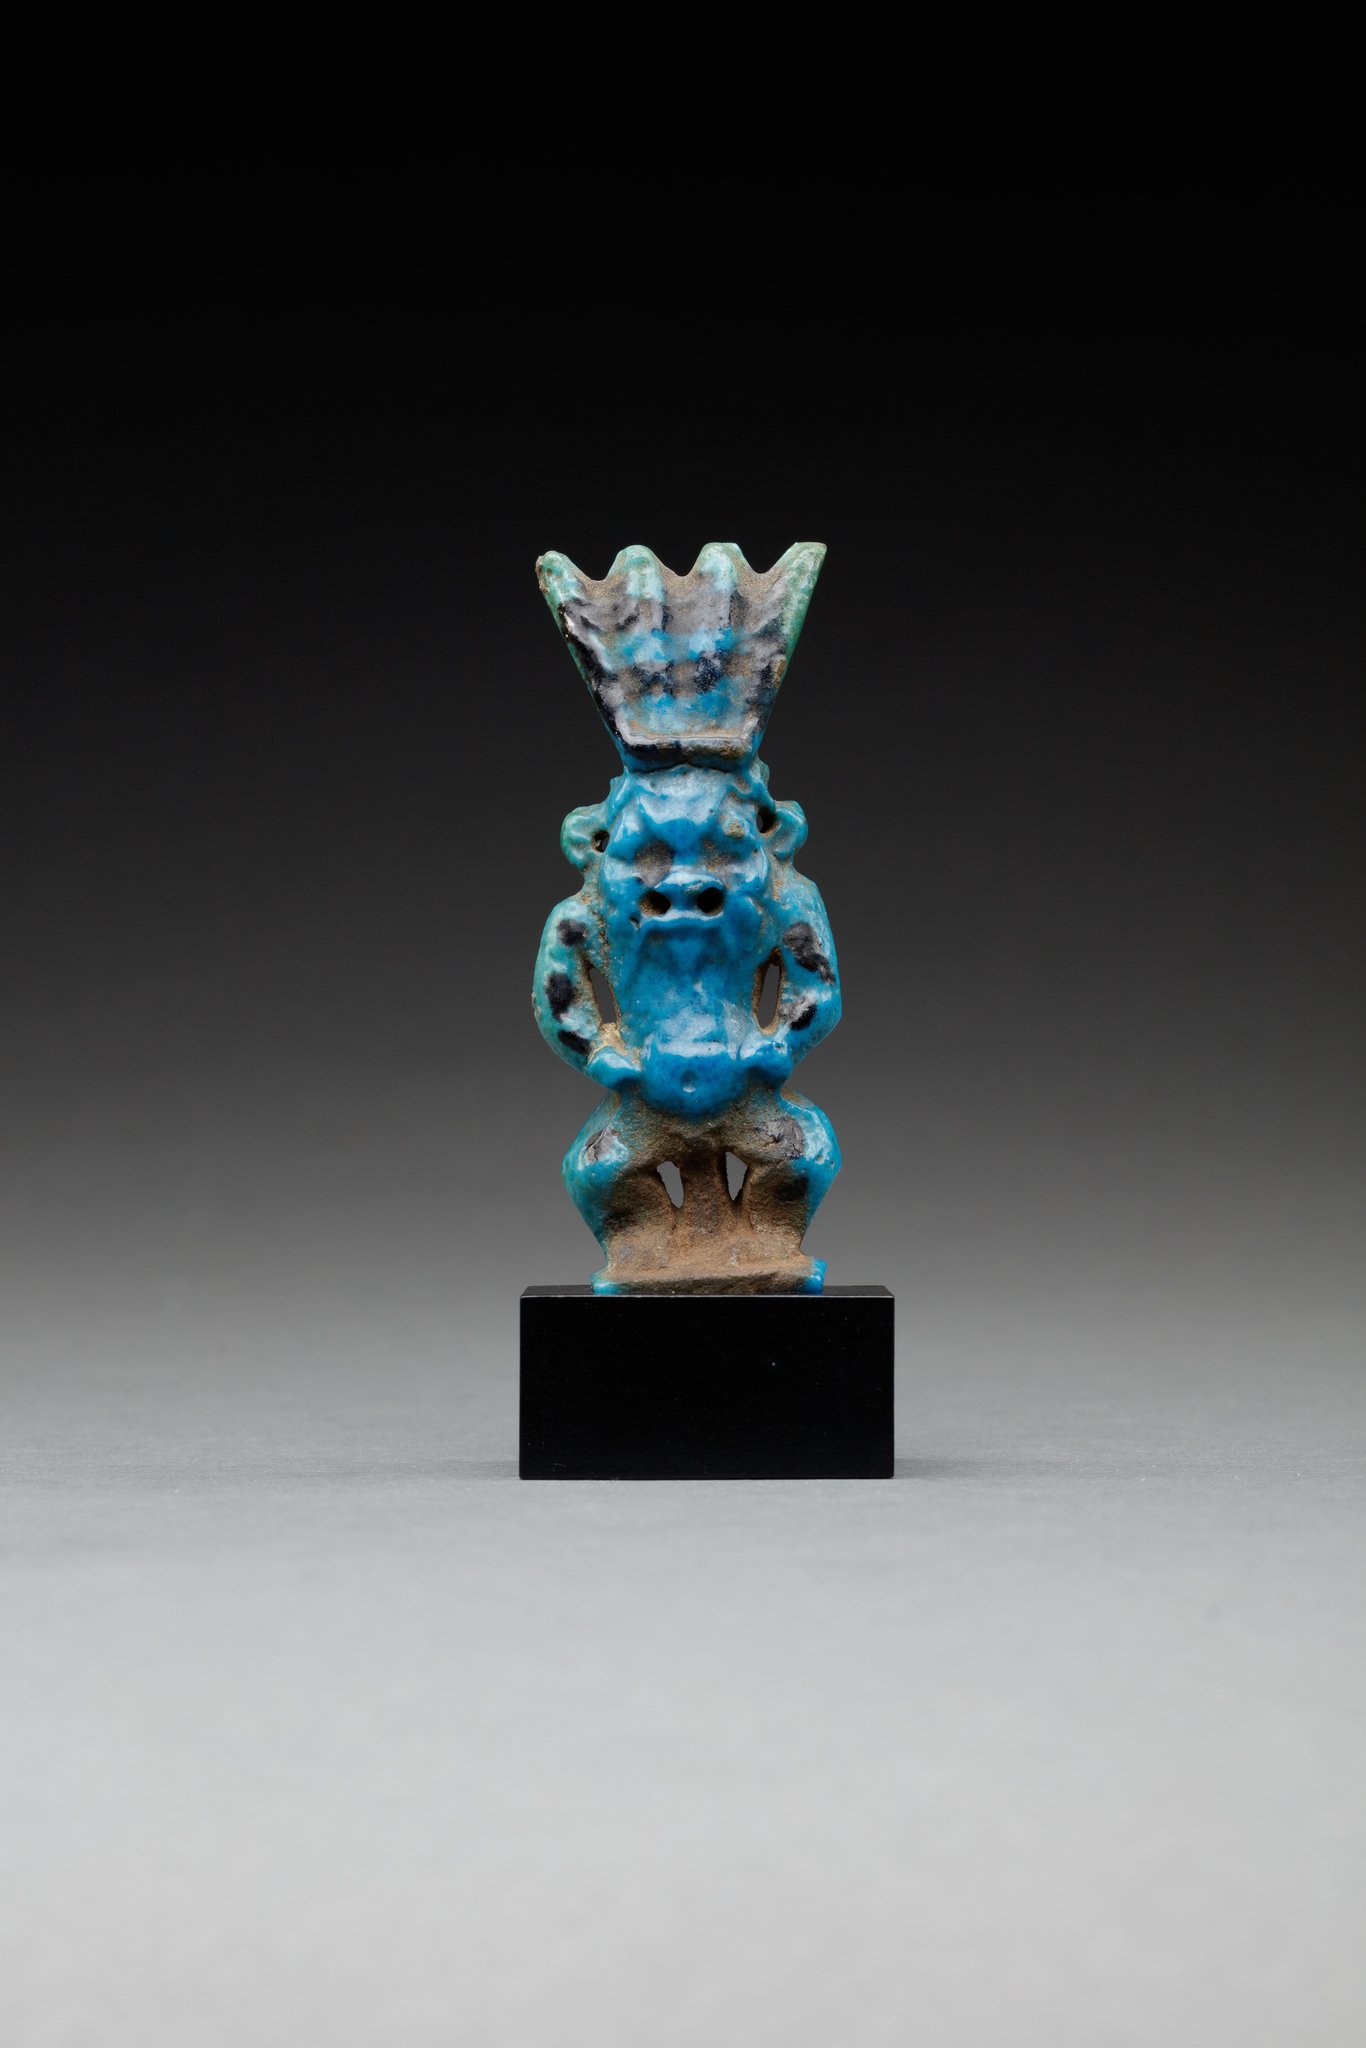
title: Amulet of a Bes-image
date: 1070-664 BCE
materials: faience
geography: egypt